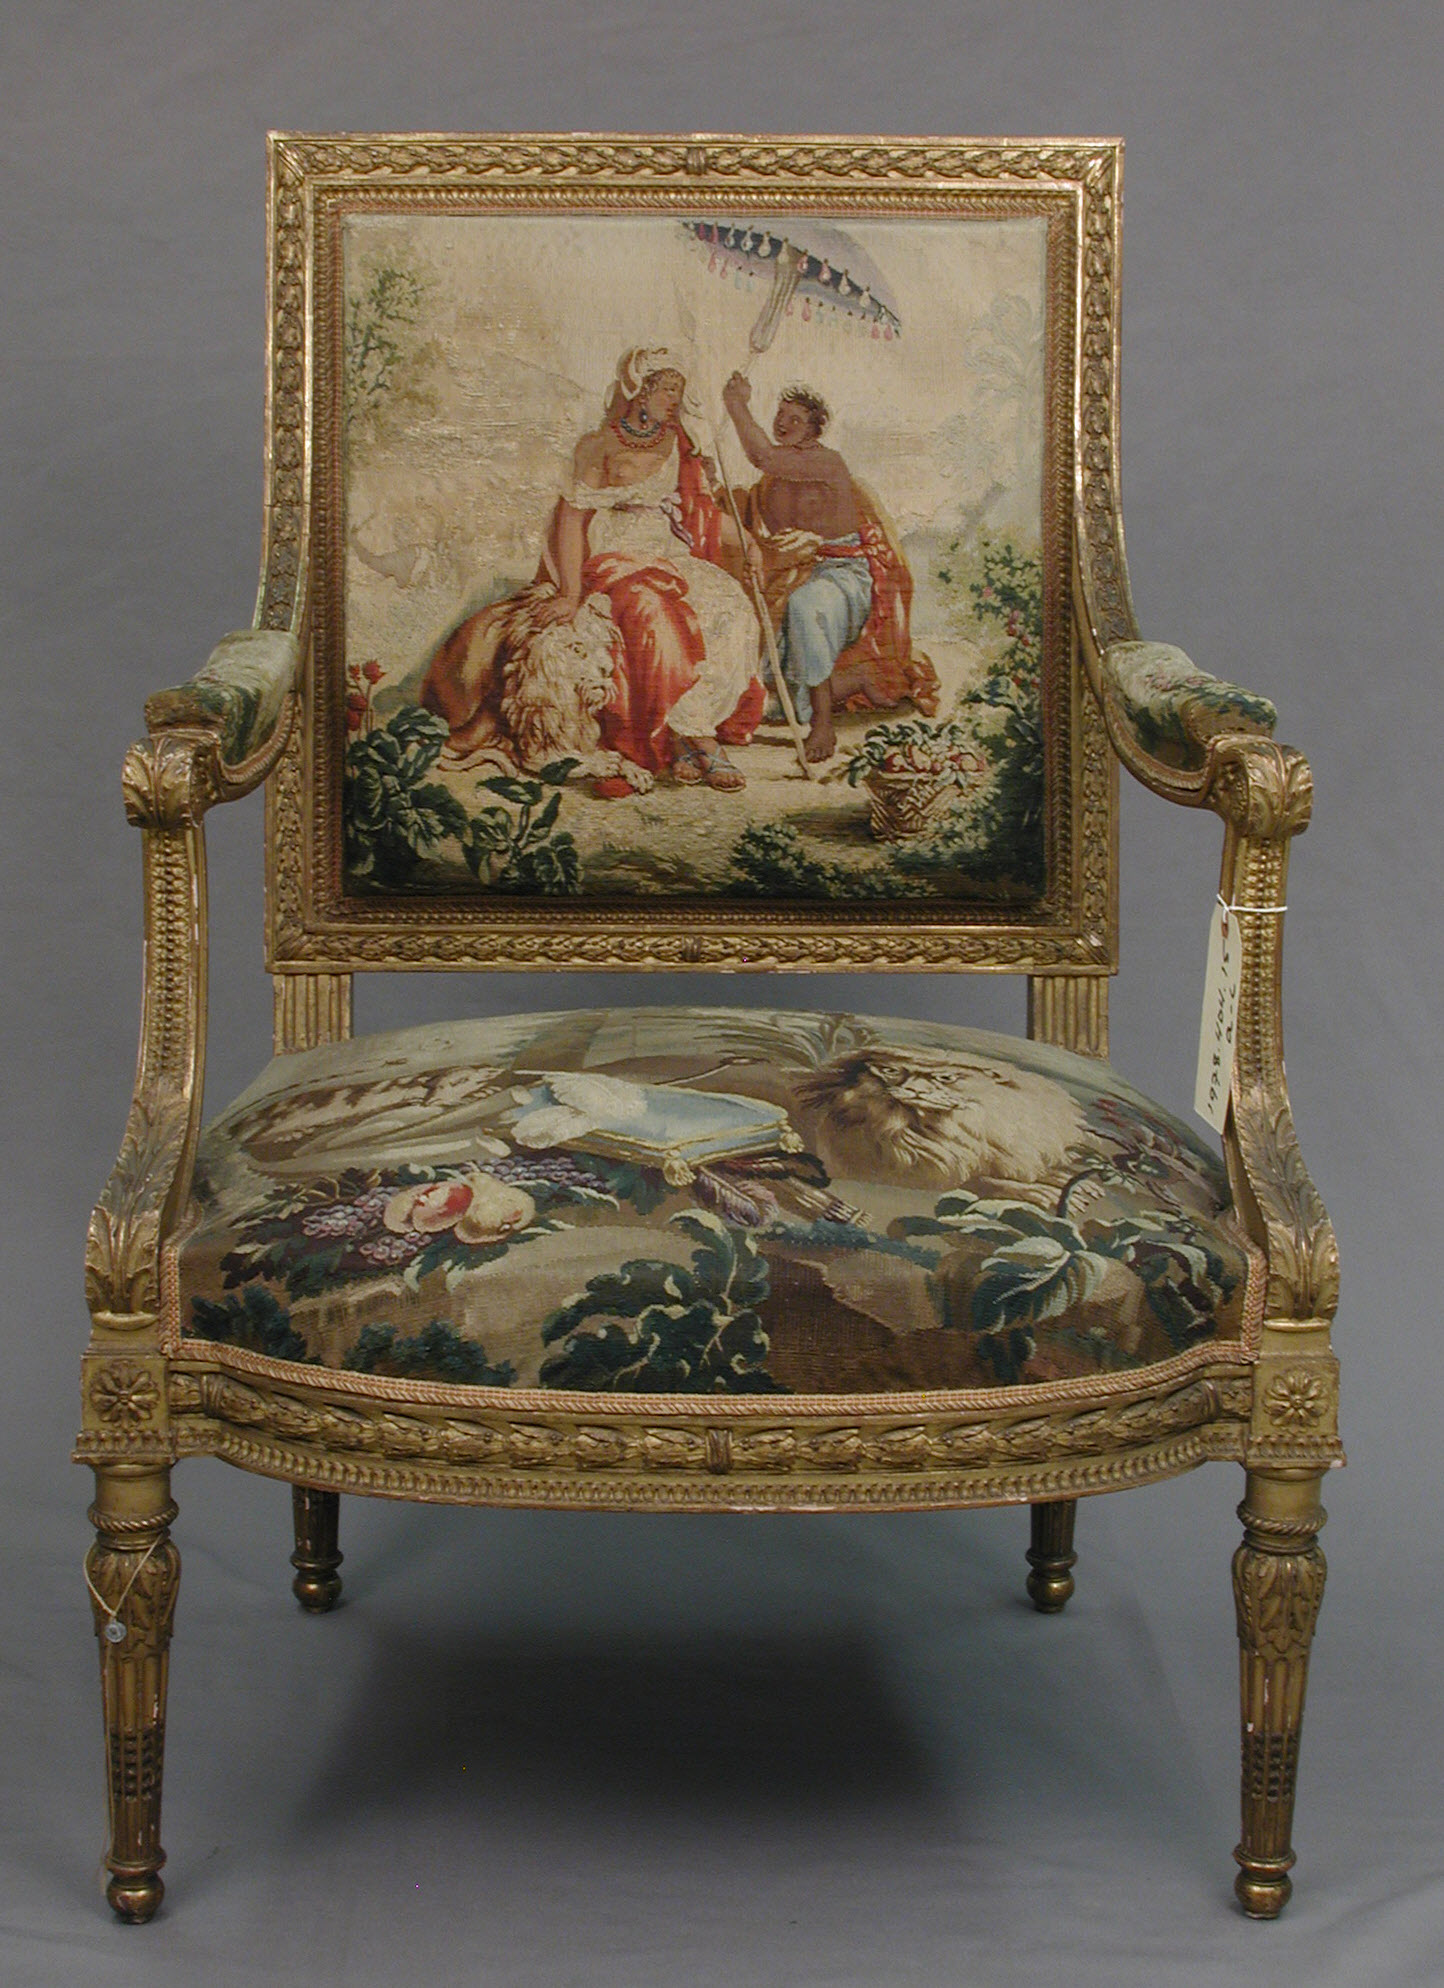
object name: armchair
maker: beauvais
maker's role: manufactory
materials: silk, wood, wool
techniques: carving, gilding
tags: fruit,women,lions